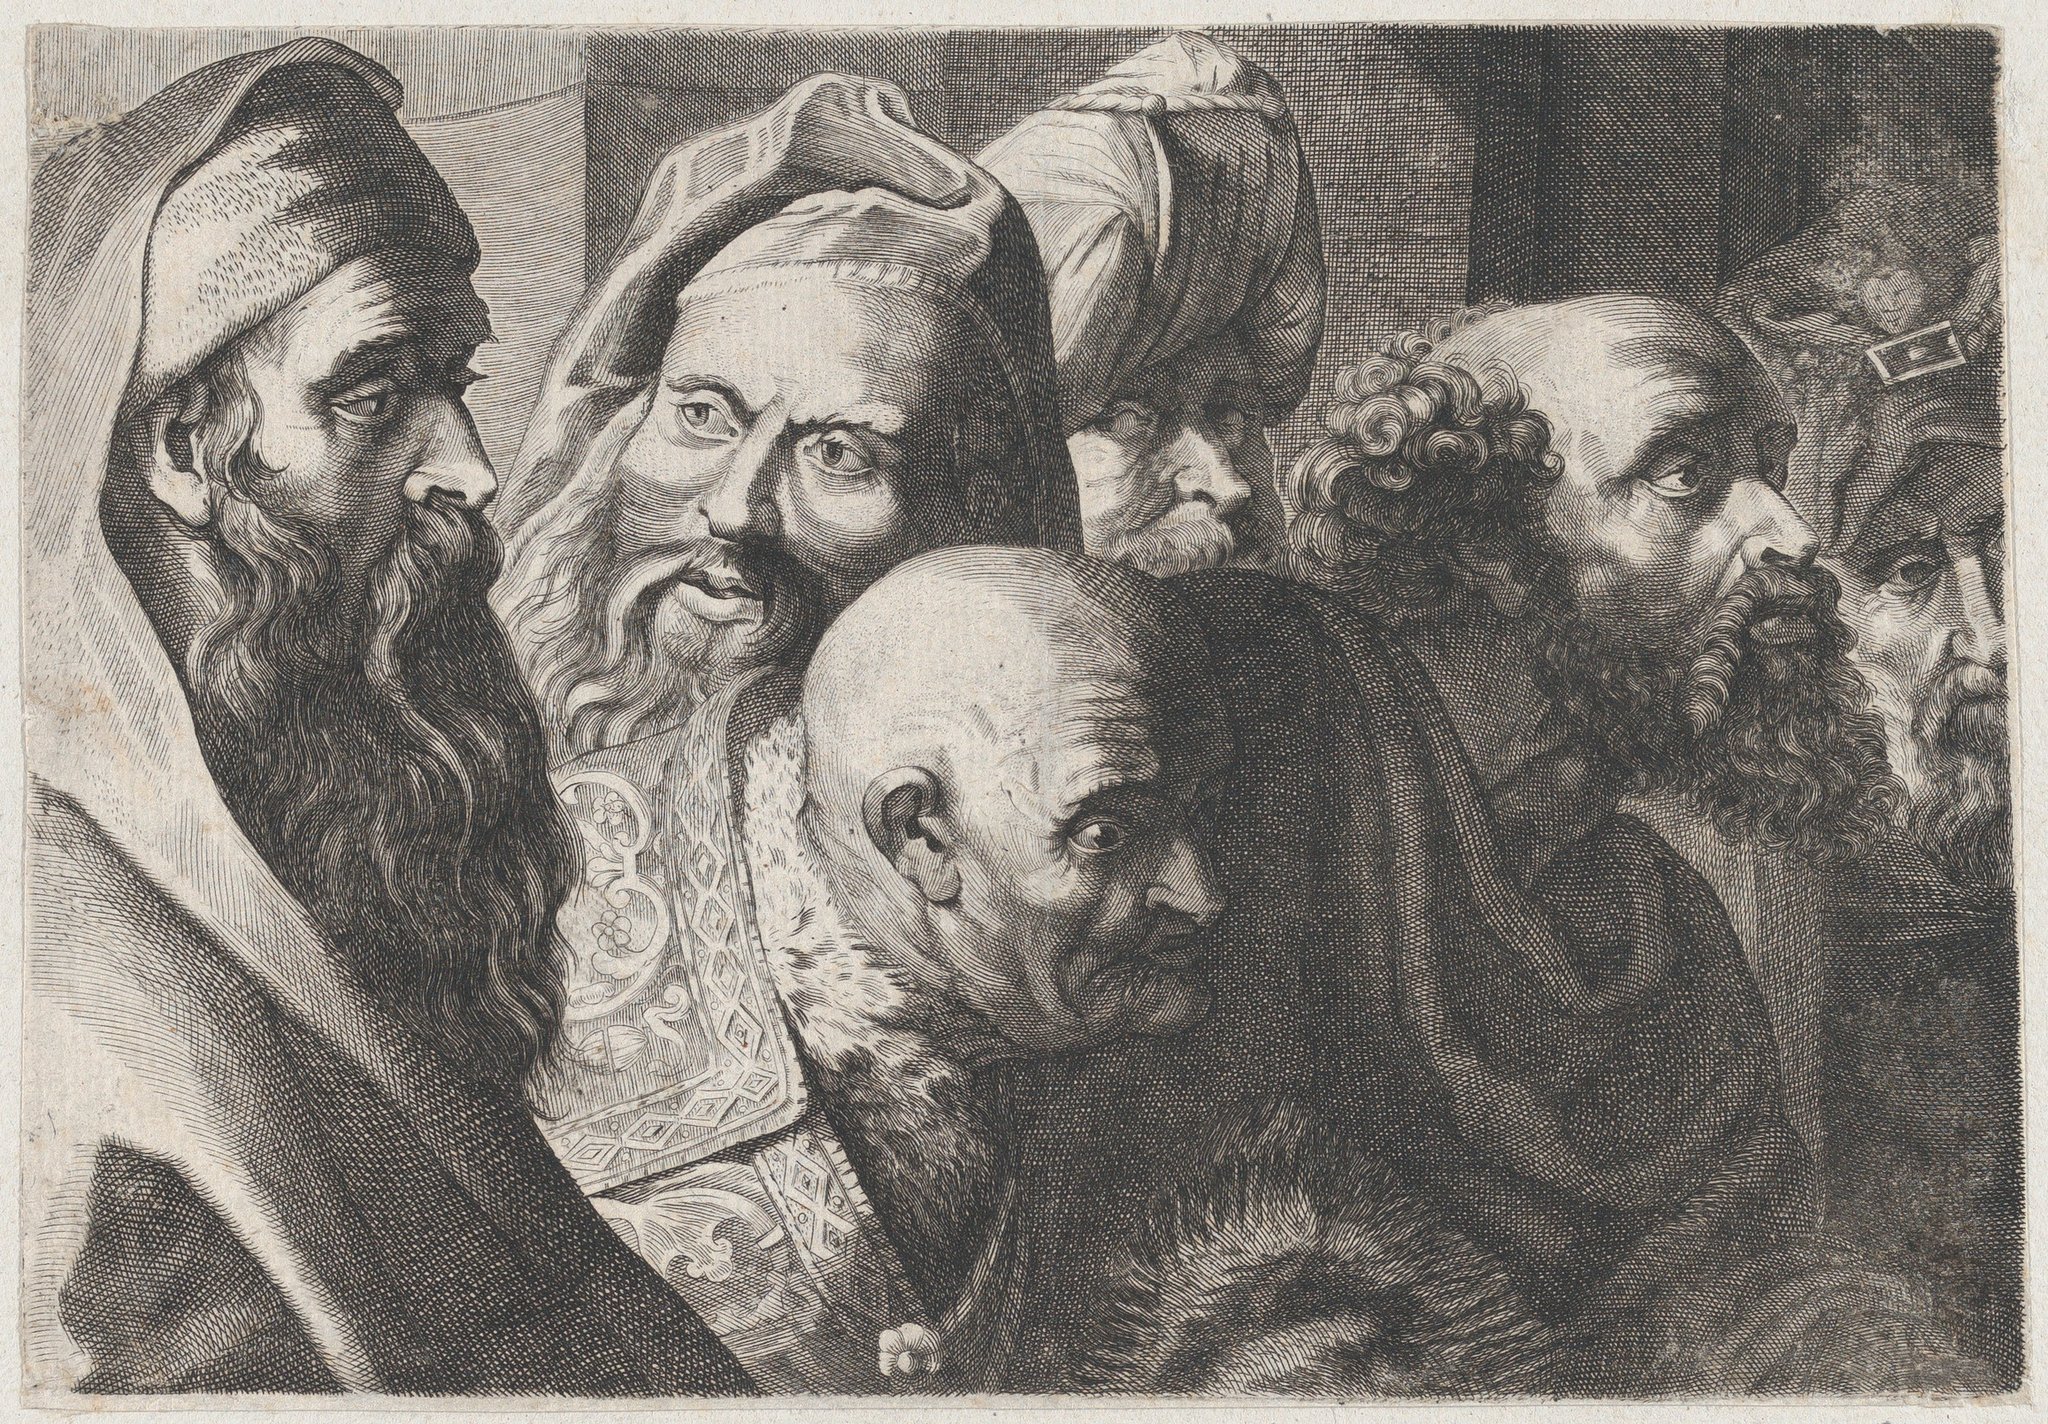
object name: print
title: The Tribute Money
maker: Anonymous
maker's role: artist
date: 1601-1800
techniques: engraving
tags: men